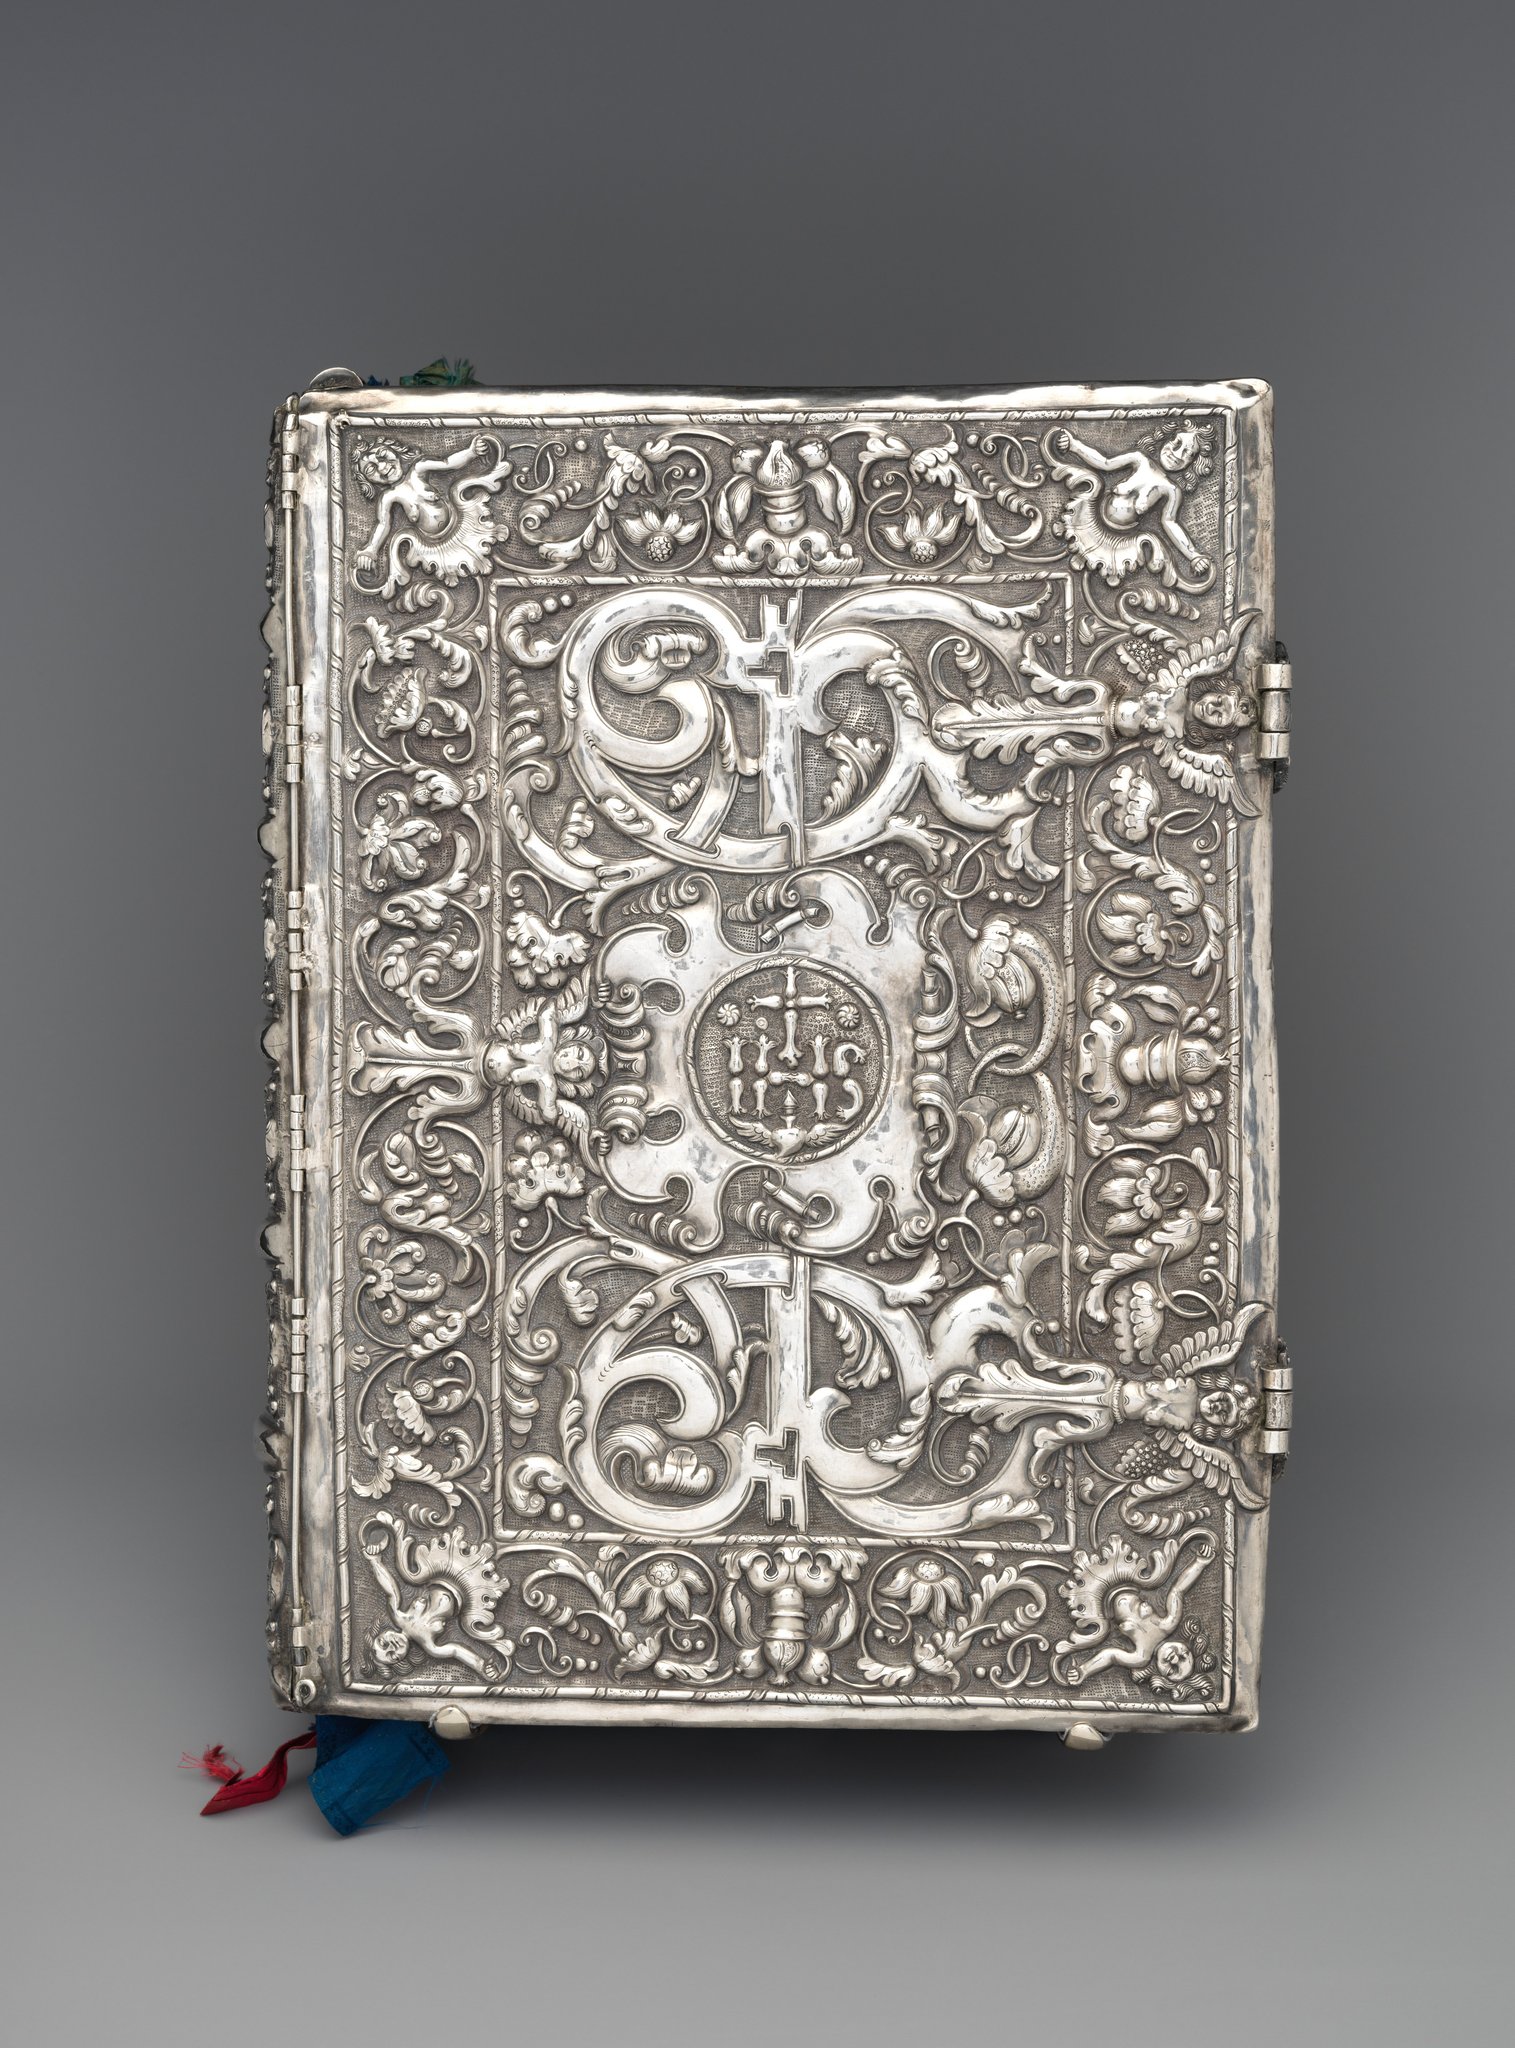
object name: missal cover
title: Missale Romanum (Roman Missal)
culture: peruvian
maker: Anonymous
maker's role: artist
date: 1710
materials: silver, wood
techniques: burnishing, casting, chasing, repoussé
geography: antwerp